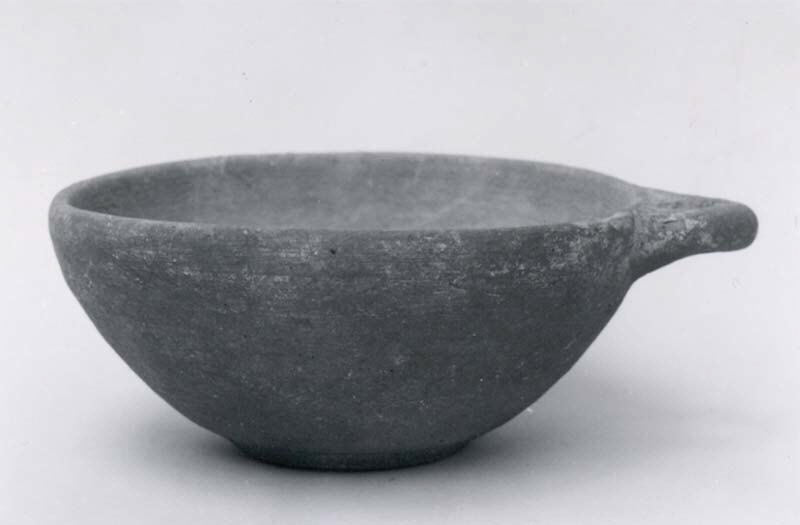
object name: bowl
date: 2000-1001 BCE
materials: ceramic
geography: iran